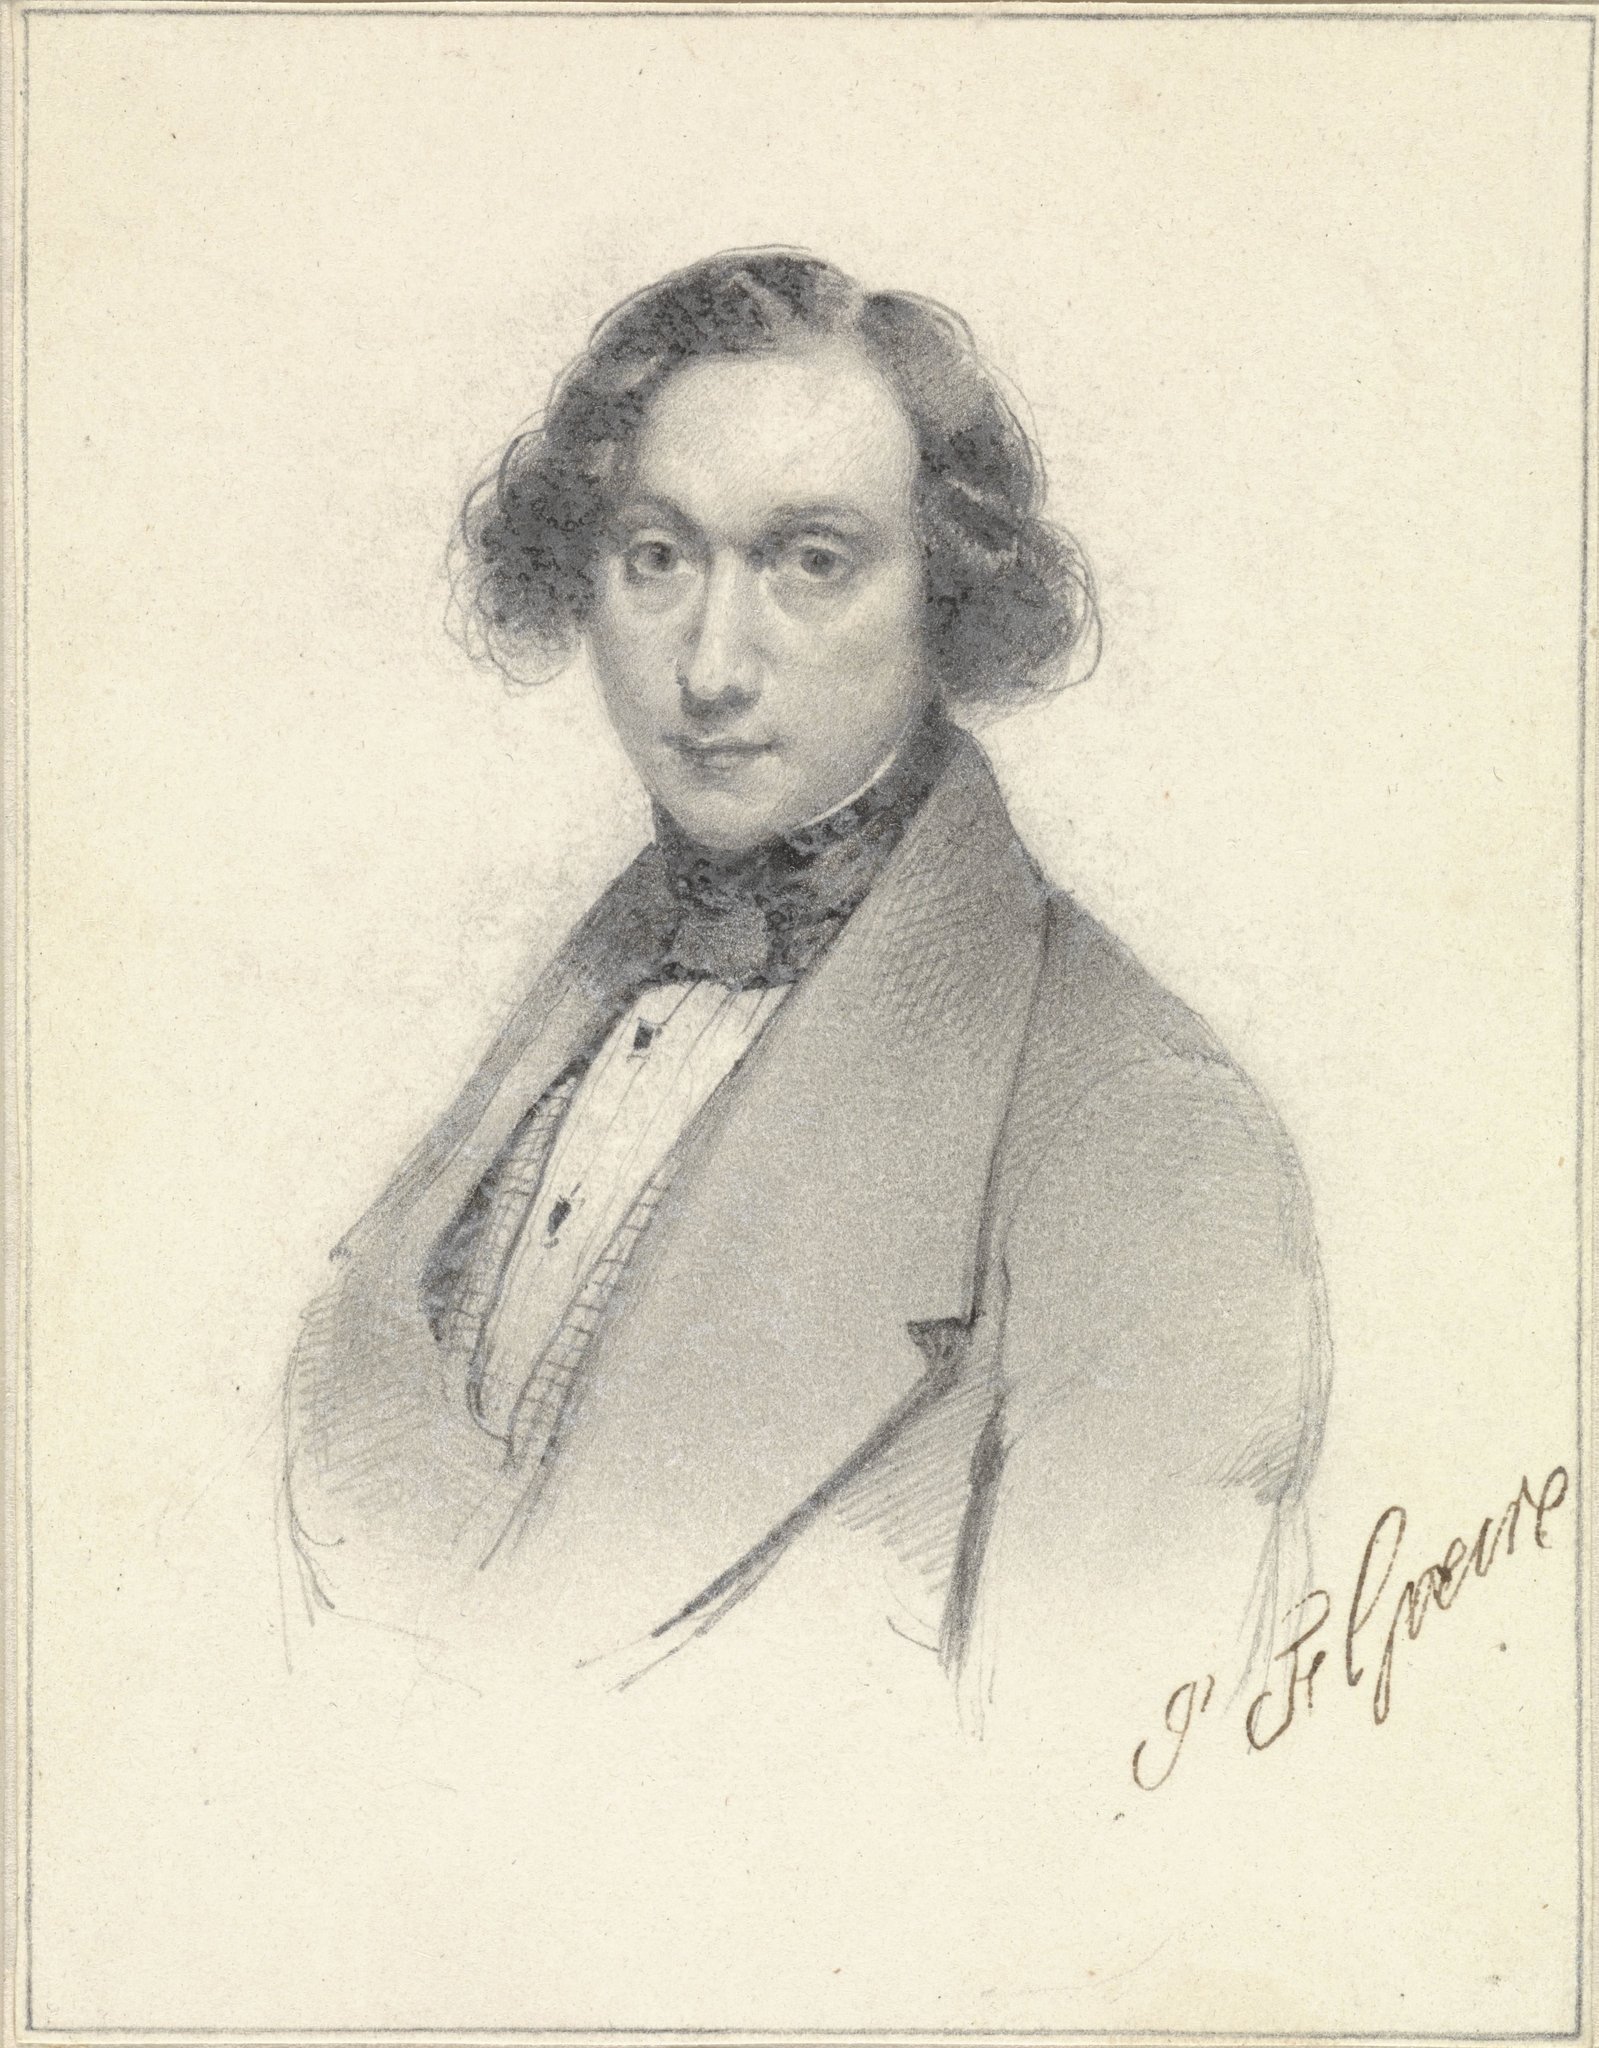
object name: drawing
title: Zelfportret van Petrus Franciscus Greive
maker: petrus franciscus greive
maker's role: draughtsman, print maker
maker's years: 1811-1872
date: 1831-1872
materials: paper, pencil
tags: amsterdam, draughtsman, petrus franciscus greive, historical persons, portrait, self-portrait of painter, portrait, self-portrait of artist, portrait, self-portrait of draughtsman